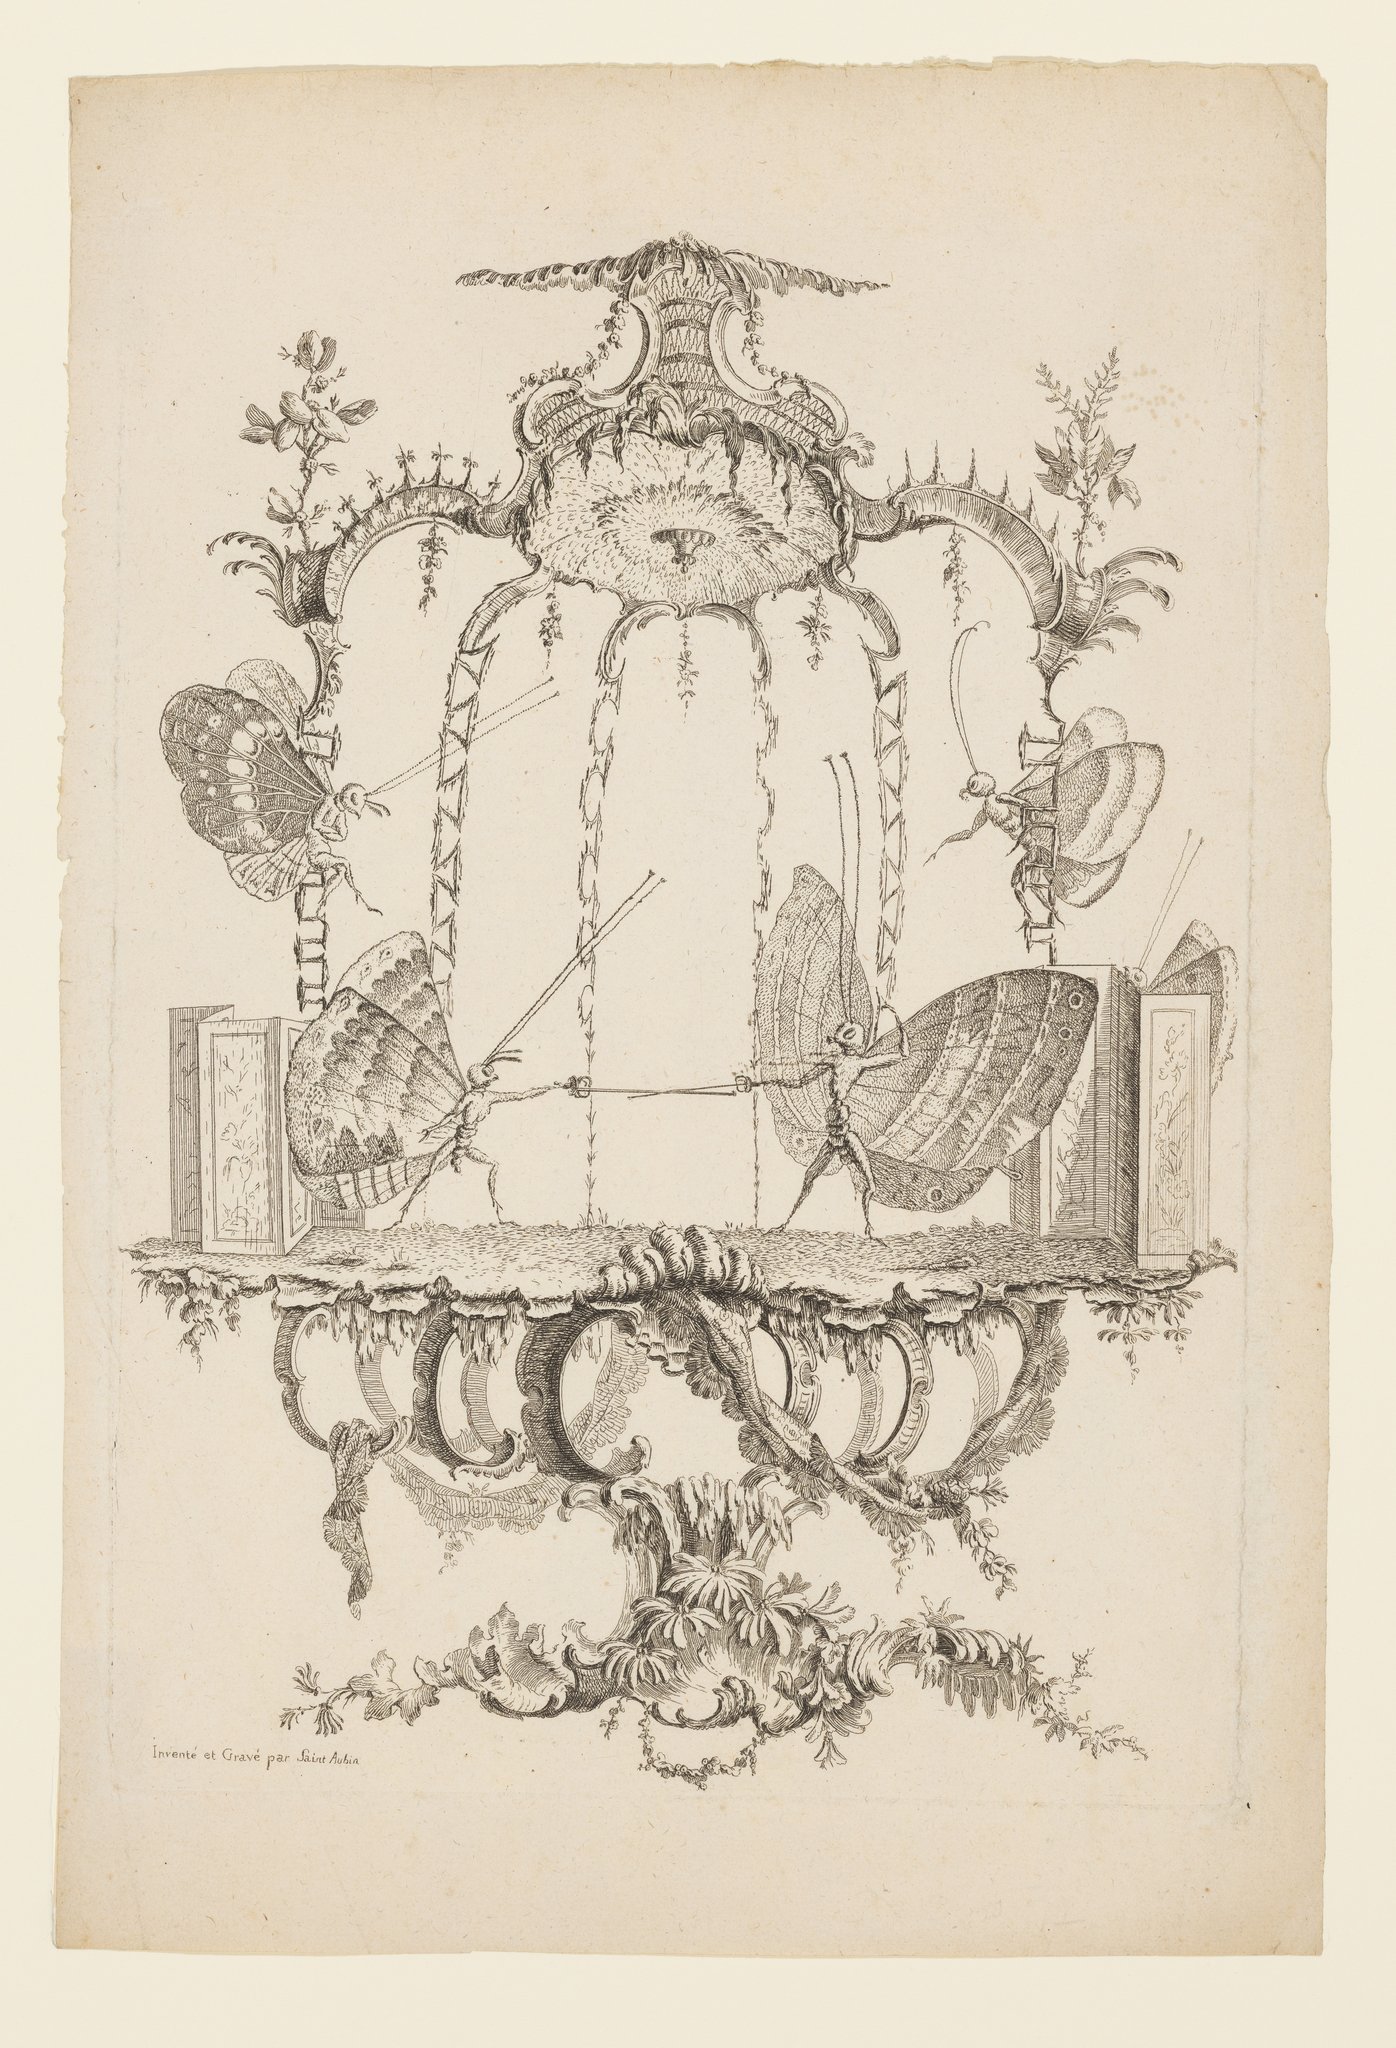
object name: print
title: The Duel (Le Duel), from Essay on Butterflies Masquerading as Humans (Essai de Papilloneries Humaines)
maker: charles germain de saint-aubin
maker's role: artist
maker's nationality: french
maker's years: 1721-1786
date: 1756-1760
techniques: etching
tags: butterflies